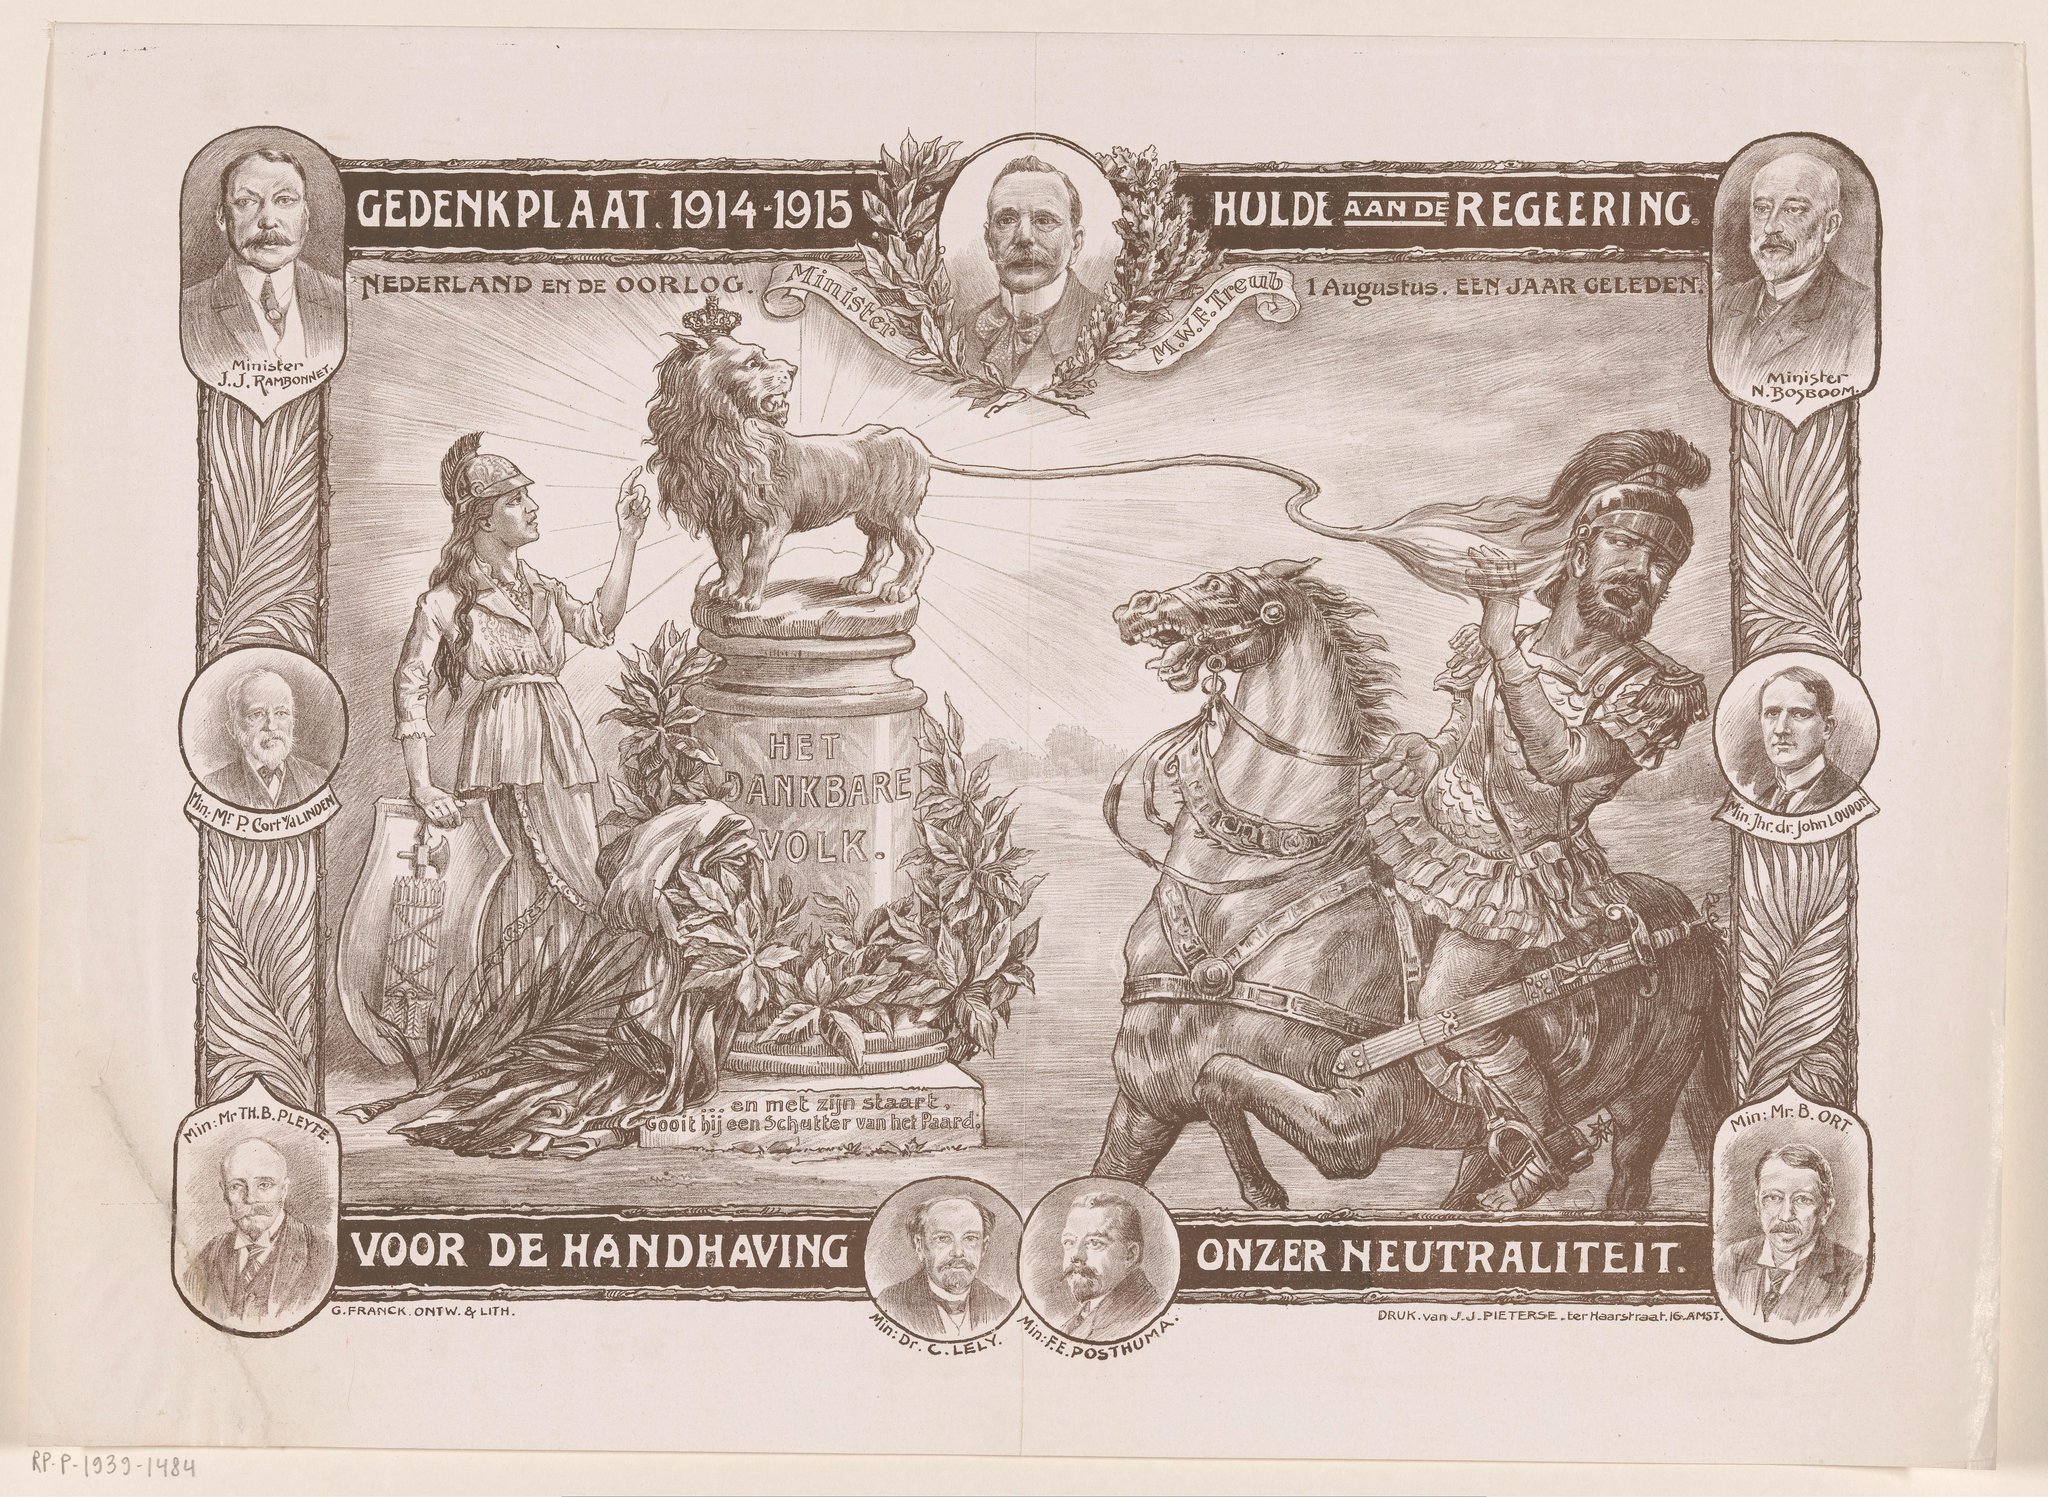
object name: print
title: Gedenkplaat 1914-15: Hulde aan de regeering voor de handhaving onzer neutraliteit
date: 1915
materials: paper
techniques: lithograph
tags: leiden, amsterdam, the hague, politician, jonkheer john loudon, voorschoten, riding a horse, ass, or mule; rider, horseman, minister ~ government, falling, beasts of prey, predatory animals: lion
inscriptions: collector's mark: Lugt 2760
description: De Nederlandse leeuw, staand op een sokkel met het opschrift 'het dankbare volk', slaat met zijn staart een ruiter van zijn paard. Naast de sokkel staat een vrouw met een wapenschild met daarop een pijlenkoker en een bijl. Rondom het geheel portretten van negen Nederlandse ministers: Willem Treub, Nicolaas Bosboom, John Loudon, Bastiaan Ort, Folkert Posthuma, Cornelis Lely, Thomas Bastiaan Pleyte, Pieter Cort van der Linden en Jean Jacques Rambonnet.